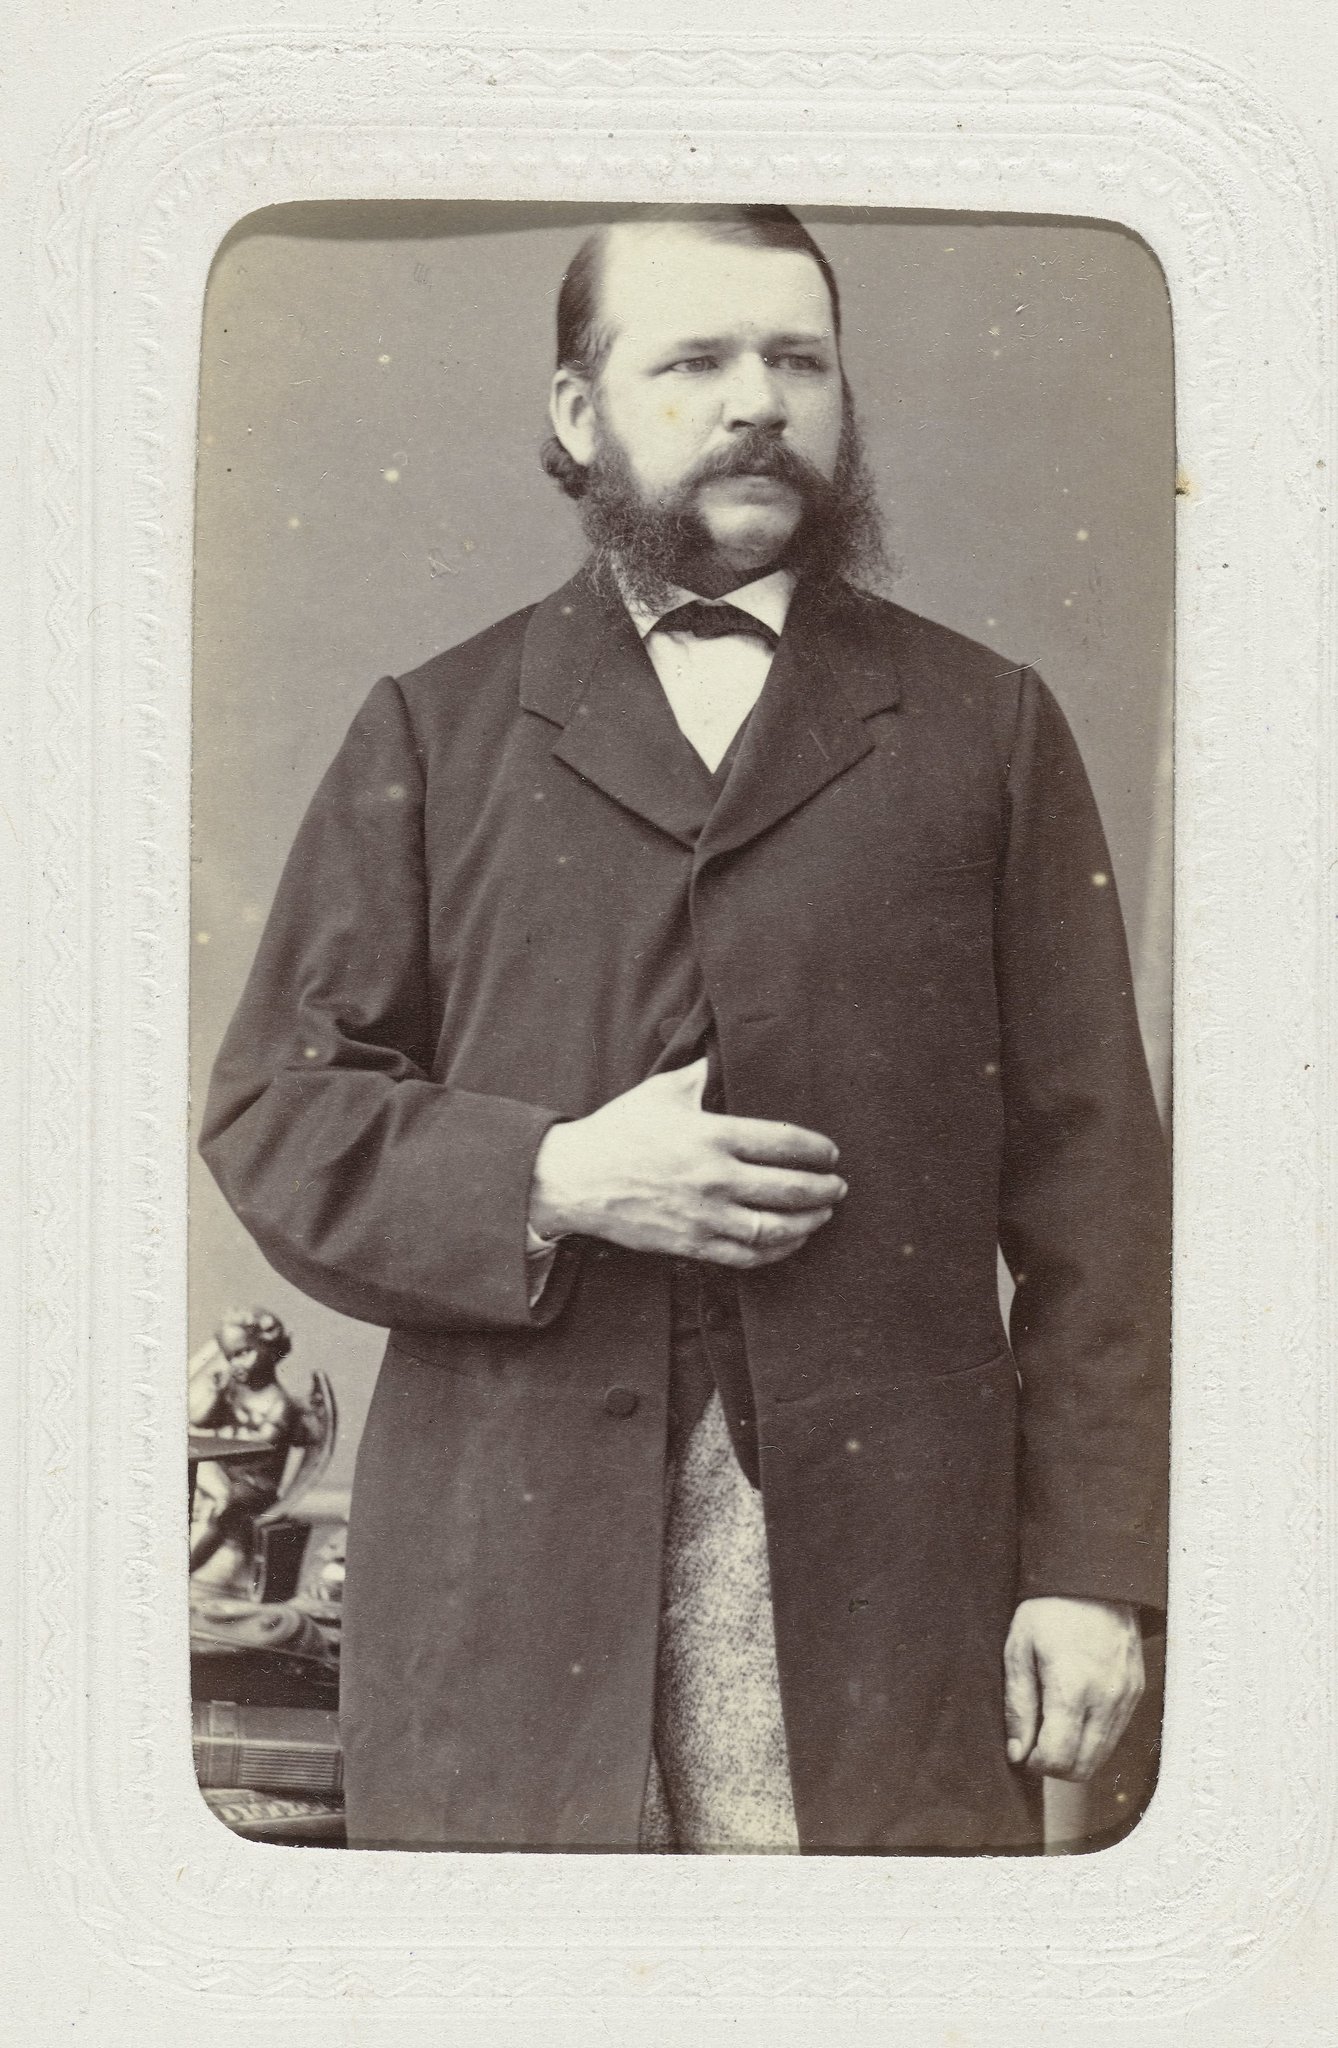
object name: carte de visite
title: Studioportret van een staande man met baard en snor bij een tafel, hij draagt een lange jas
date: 1863-1866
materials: cardboard, paper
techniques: albumen print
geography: istanbul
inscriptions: stamp: ‘Abdullah freres Constantinopel’, name: ‘maccas’